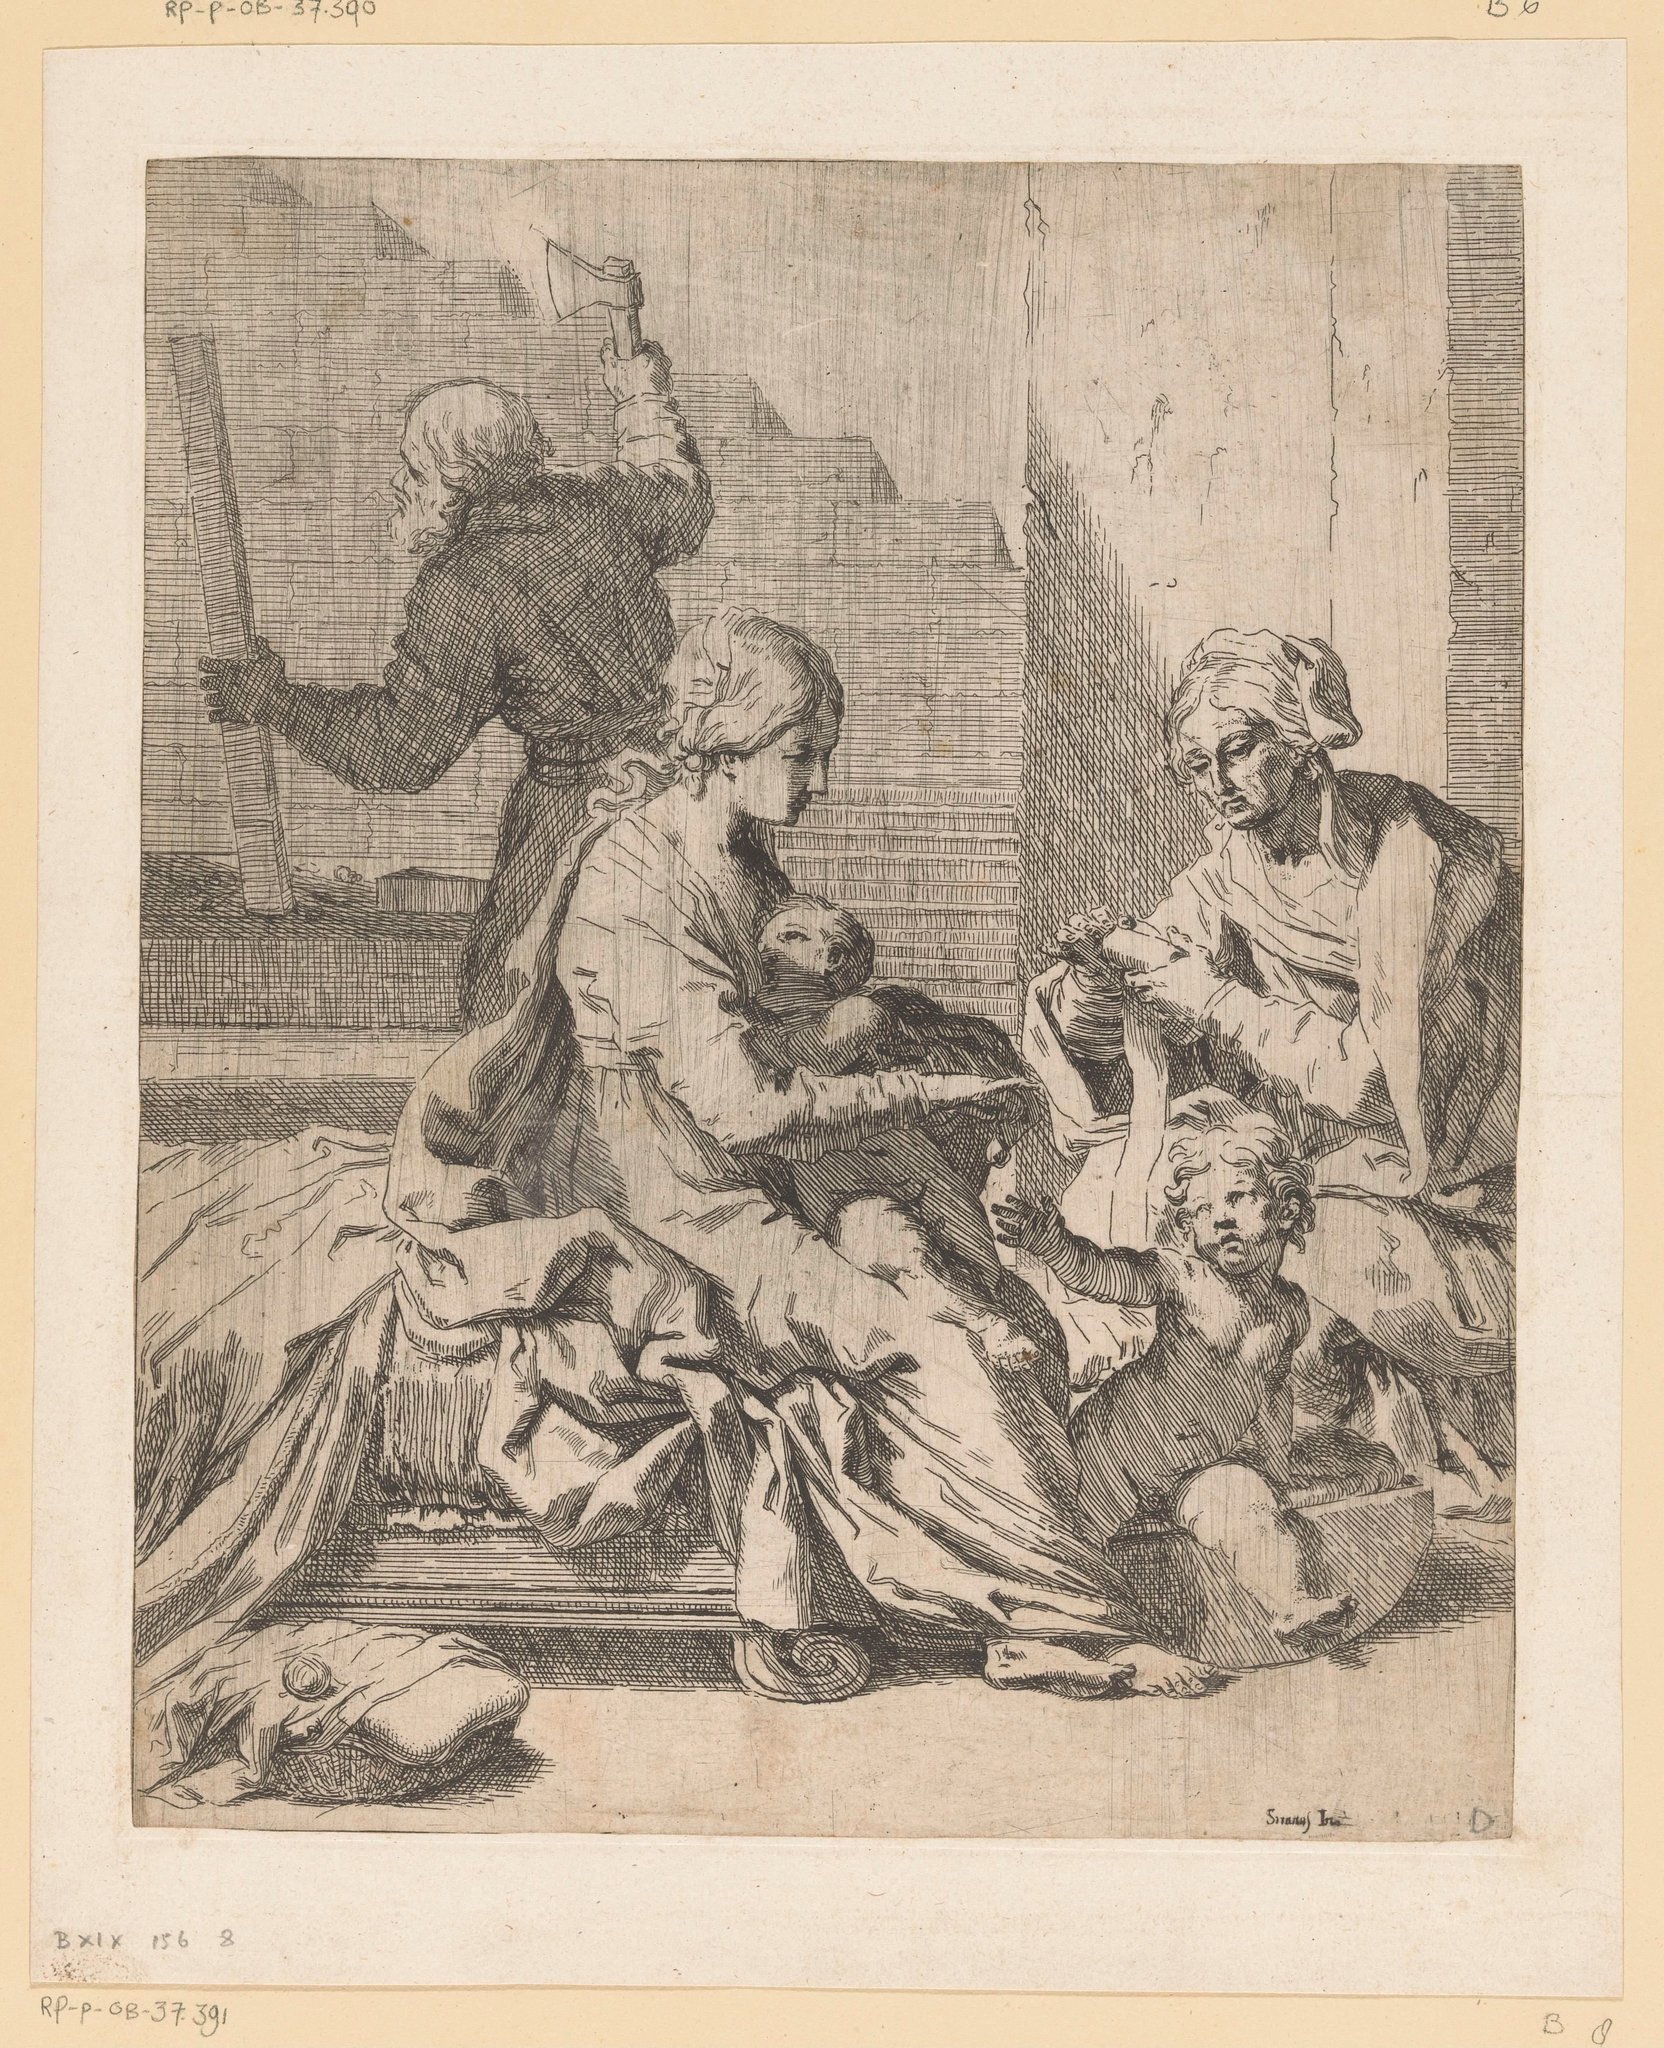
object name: print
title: Heilige Familie met Johannes de Doper en Elisabet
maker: elisabetta sirani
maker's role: draughtsman, print maker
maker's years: 1638-1665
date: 1648-1665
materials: paper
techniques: etching, intaglio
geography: italy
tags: christ-child suckling, or beginning to suckle, e.g. mary uncovering her breast ~ madonna-representations, holy family with john the baptist, elisabeth present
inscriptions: collector's mark: Lugt 240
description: Op de voorgrond geeft Maria de borst aan het Christuskind. Bij haar zitten de jonge Johannes de Doper en zijn moeder Elisabet. Op de achtergrond is Jozef aan het werk met een bijl.